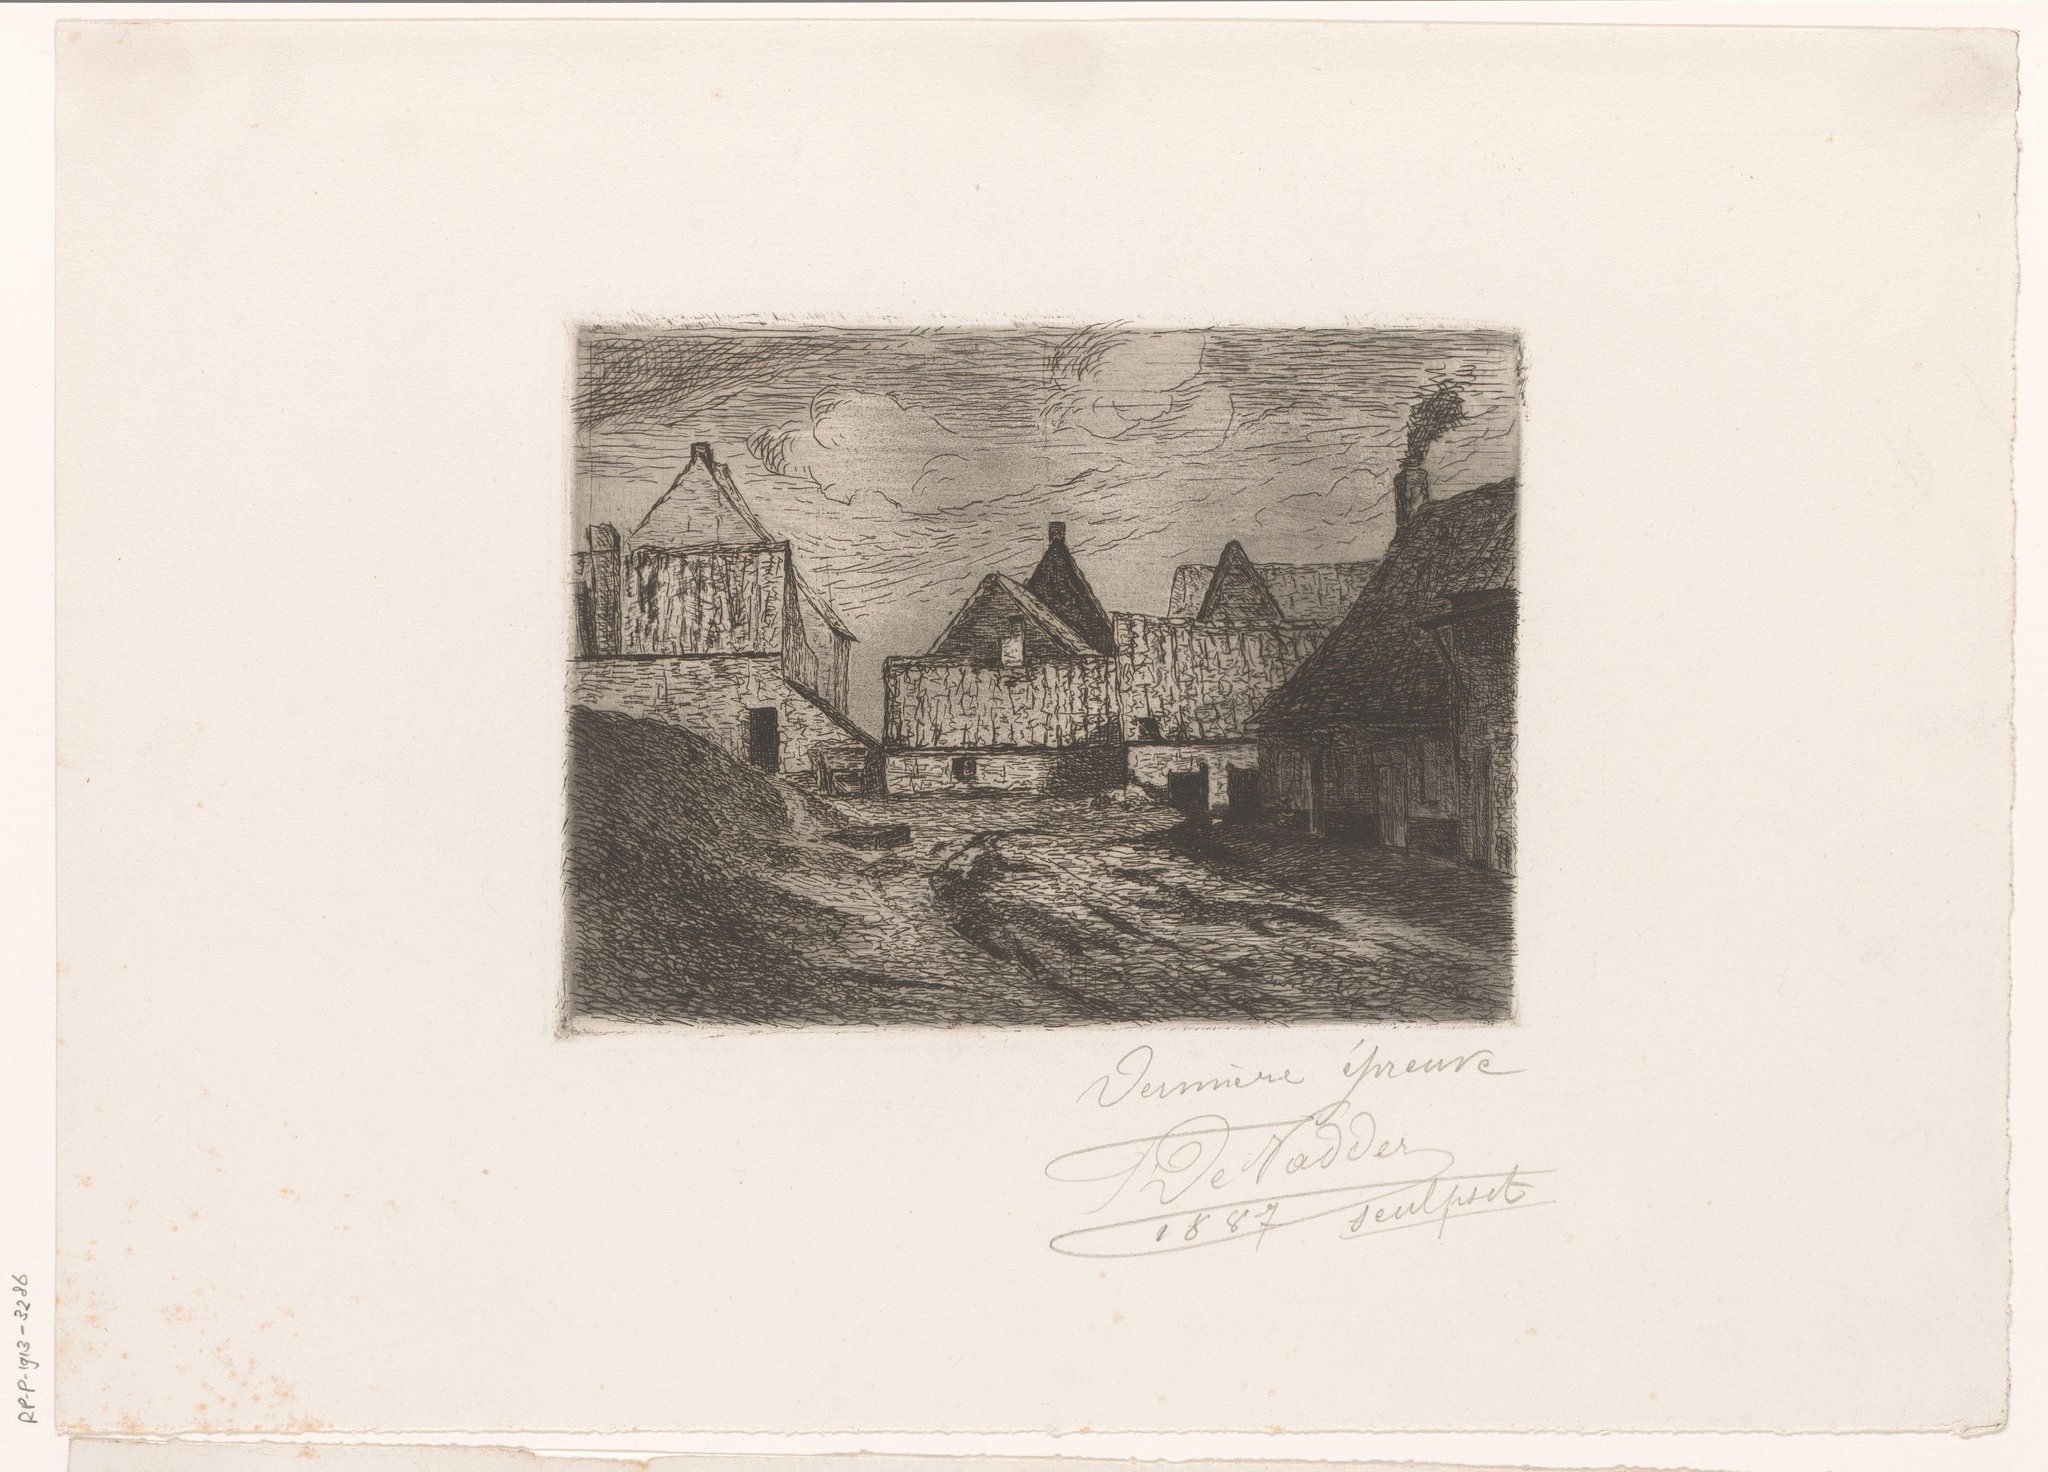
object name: print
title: Boerenerf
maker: frans de vadder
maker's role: print maker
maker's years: 1862-1936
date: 1887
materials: paper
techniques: aquatint, drypoint, etching, intaglio, retroussage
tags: courtyard, farm or solitary house in landscape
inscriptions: inscription: ‘Dernière épreuve; 1887 sculpsit’, collector's mark: Lugt 2228